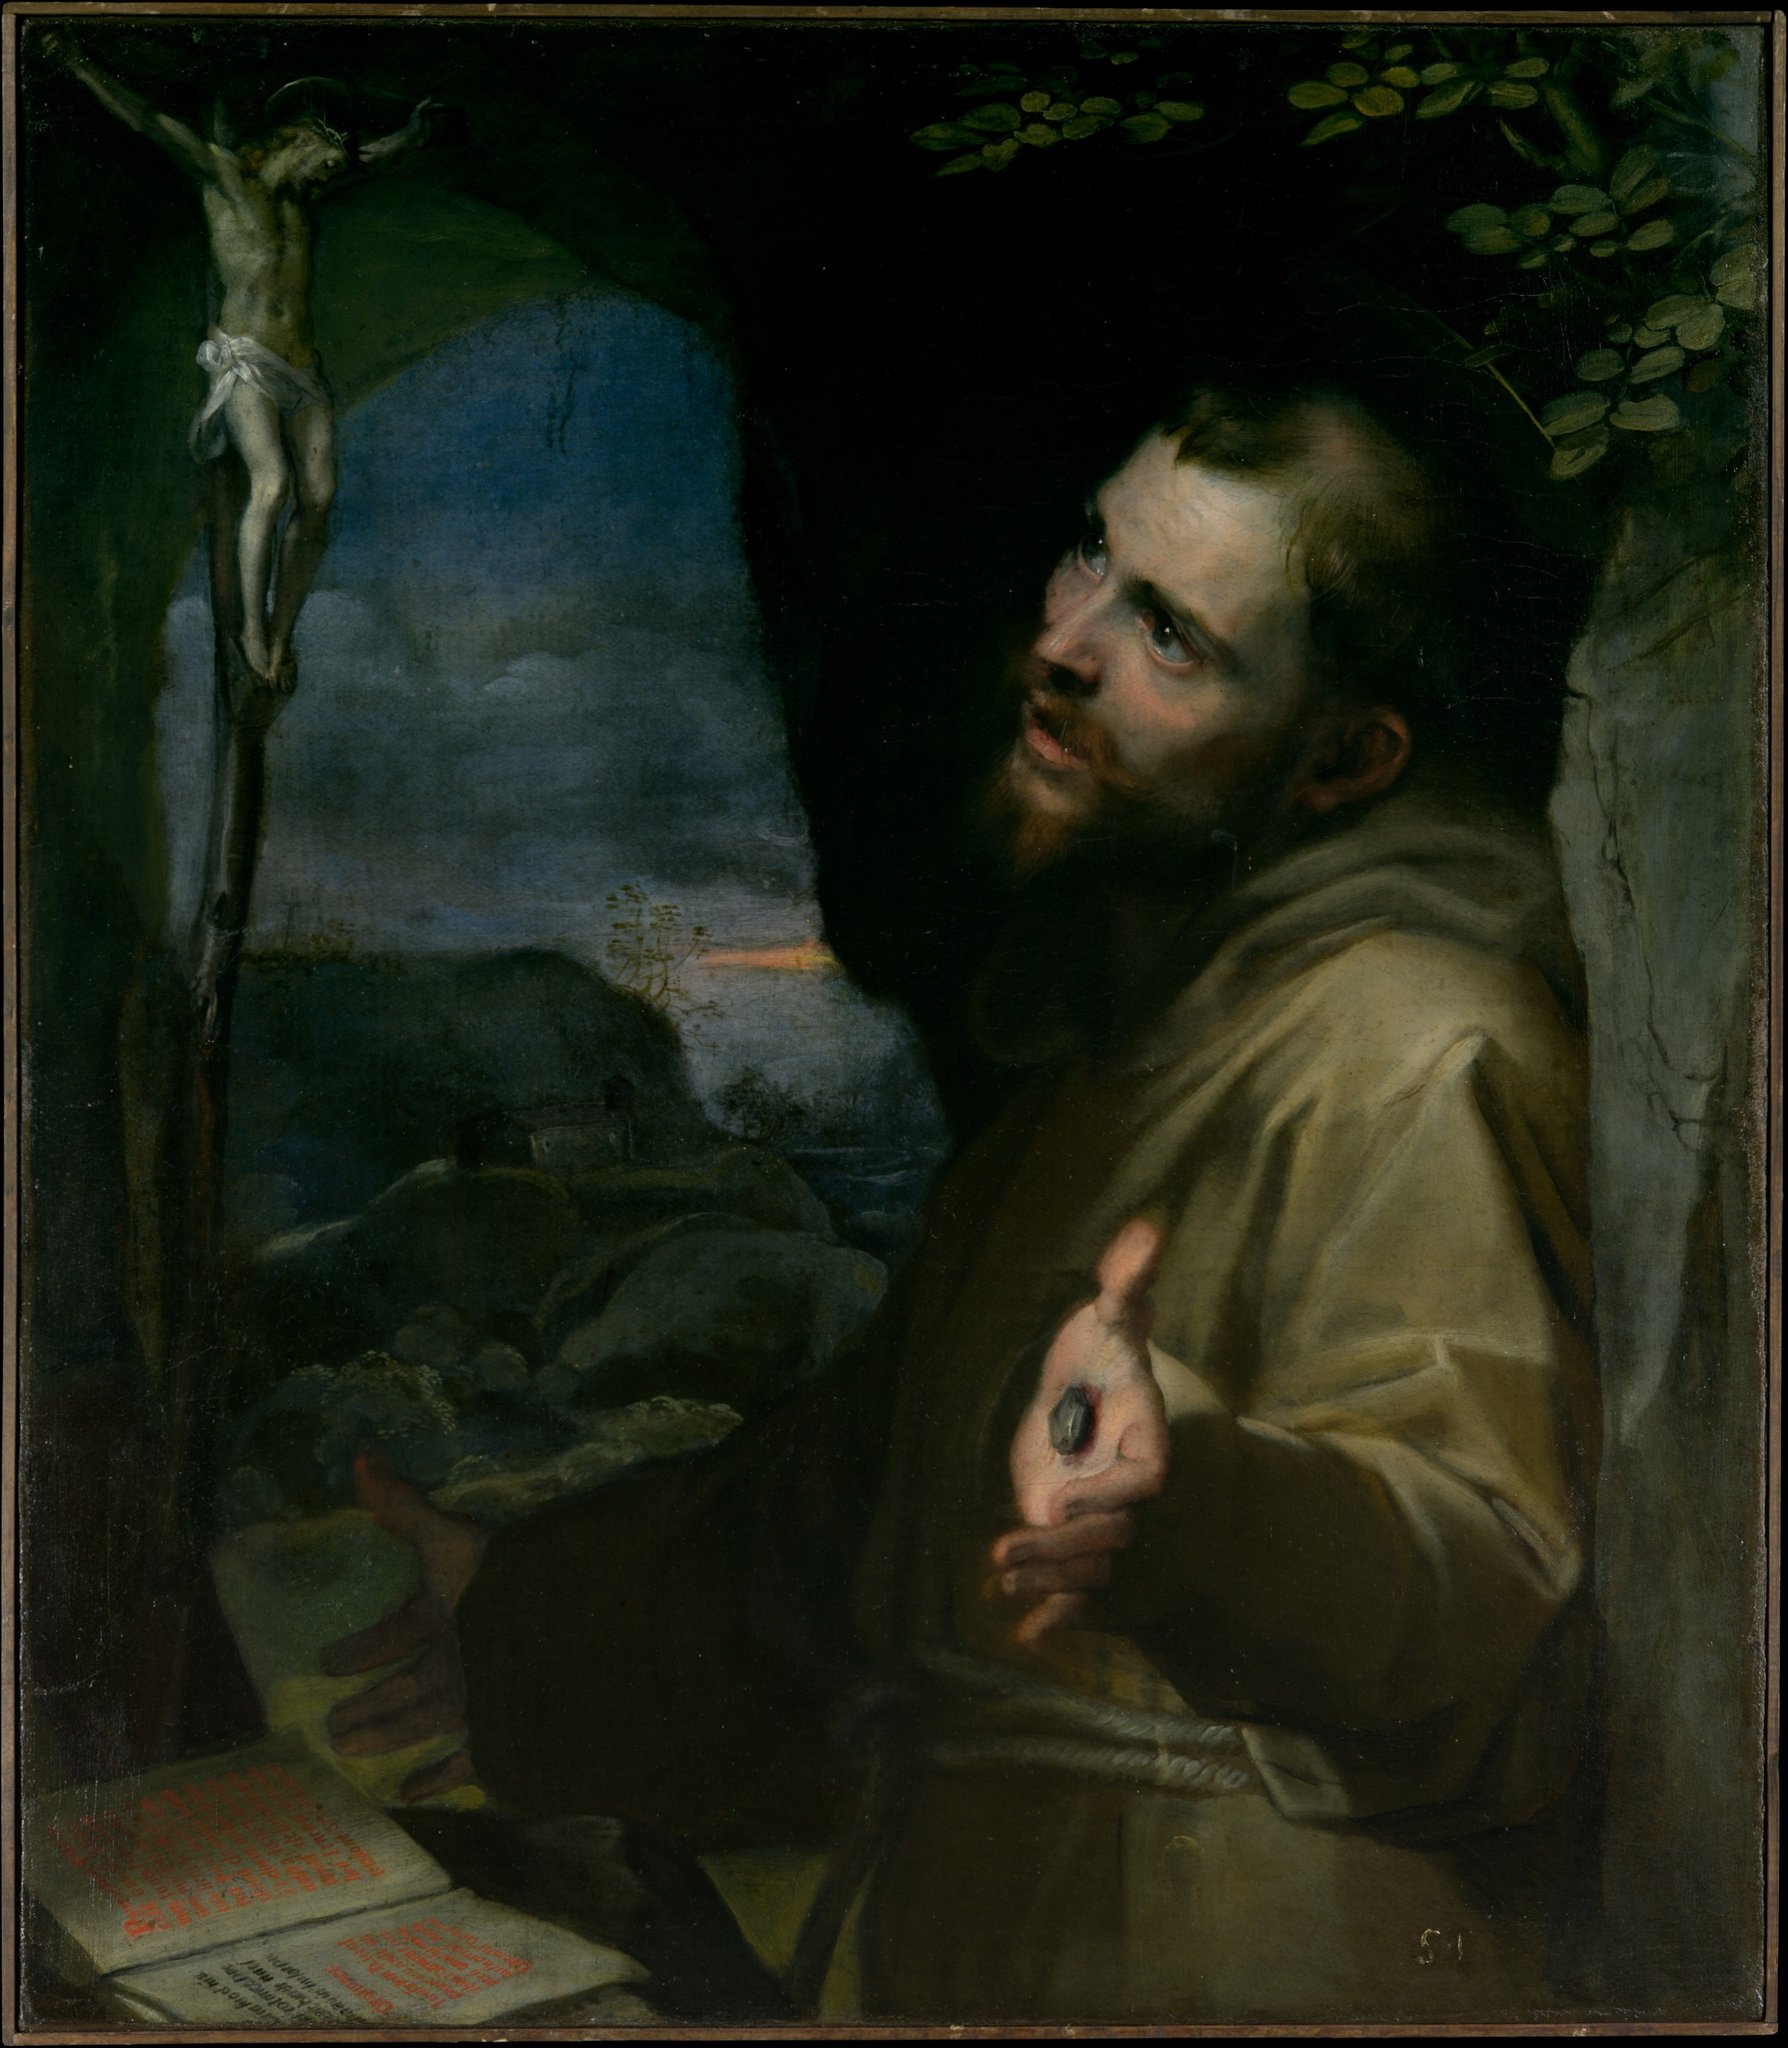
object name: painting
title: Saint Francis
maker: federico barocci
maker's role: artist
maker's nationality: italian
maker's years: 1535-1612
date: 1600-1604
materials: canvas, oil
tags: books,christ,saint francis